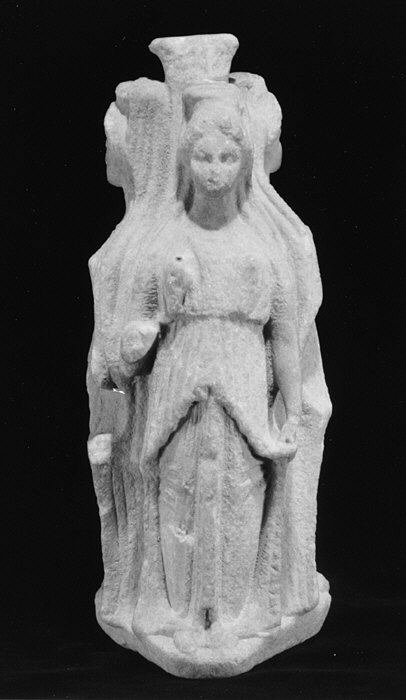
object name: statuette of hekate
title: Marble statuette of the goddess Hekate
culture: roman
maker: alkamenes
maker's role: artist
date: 1-200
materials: marble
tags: goddess